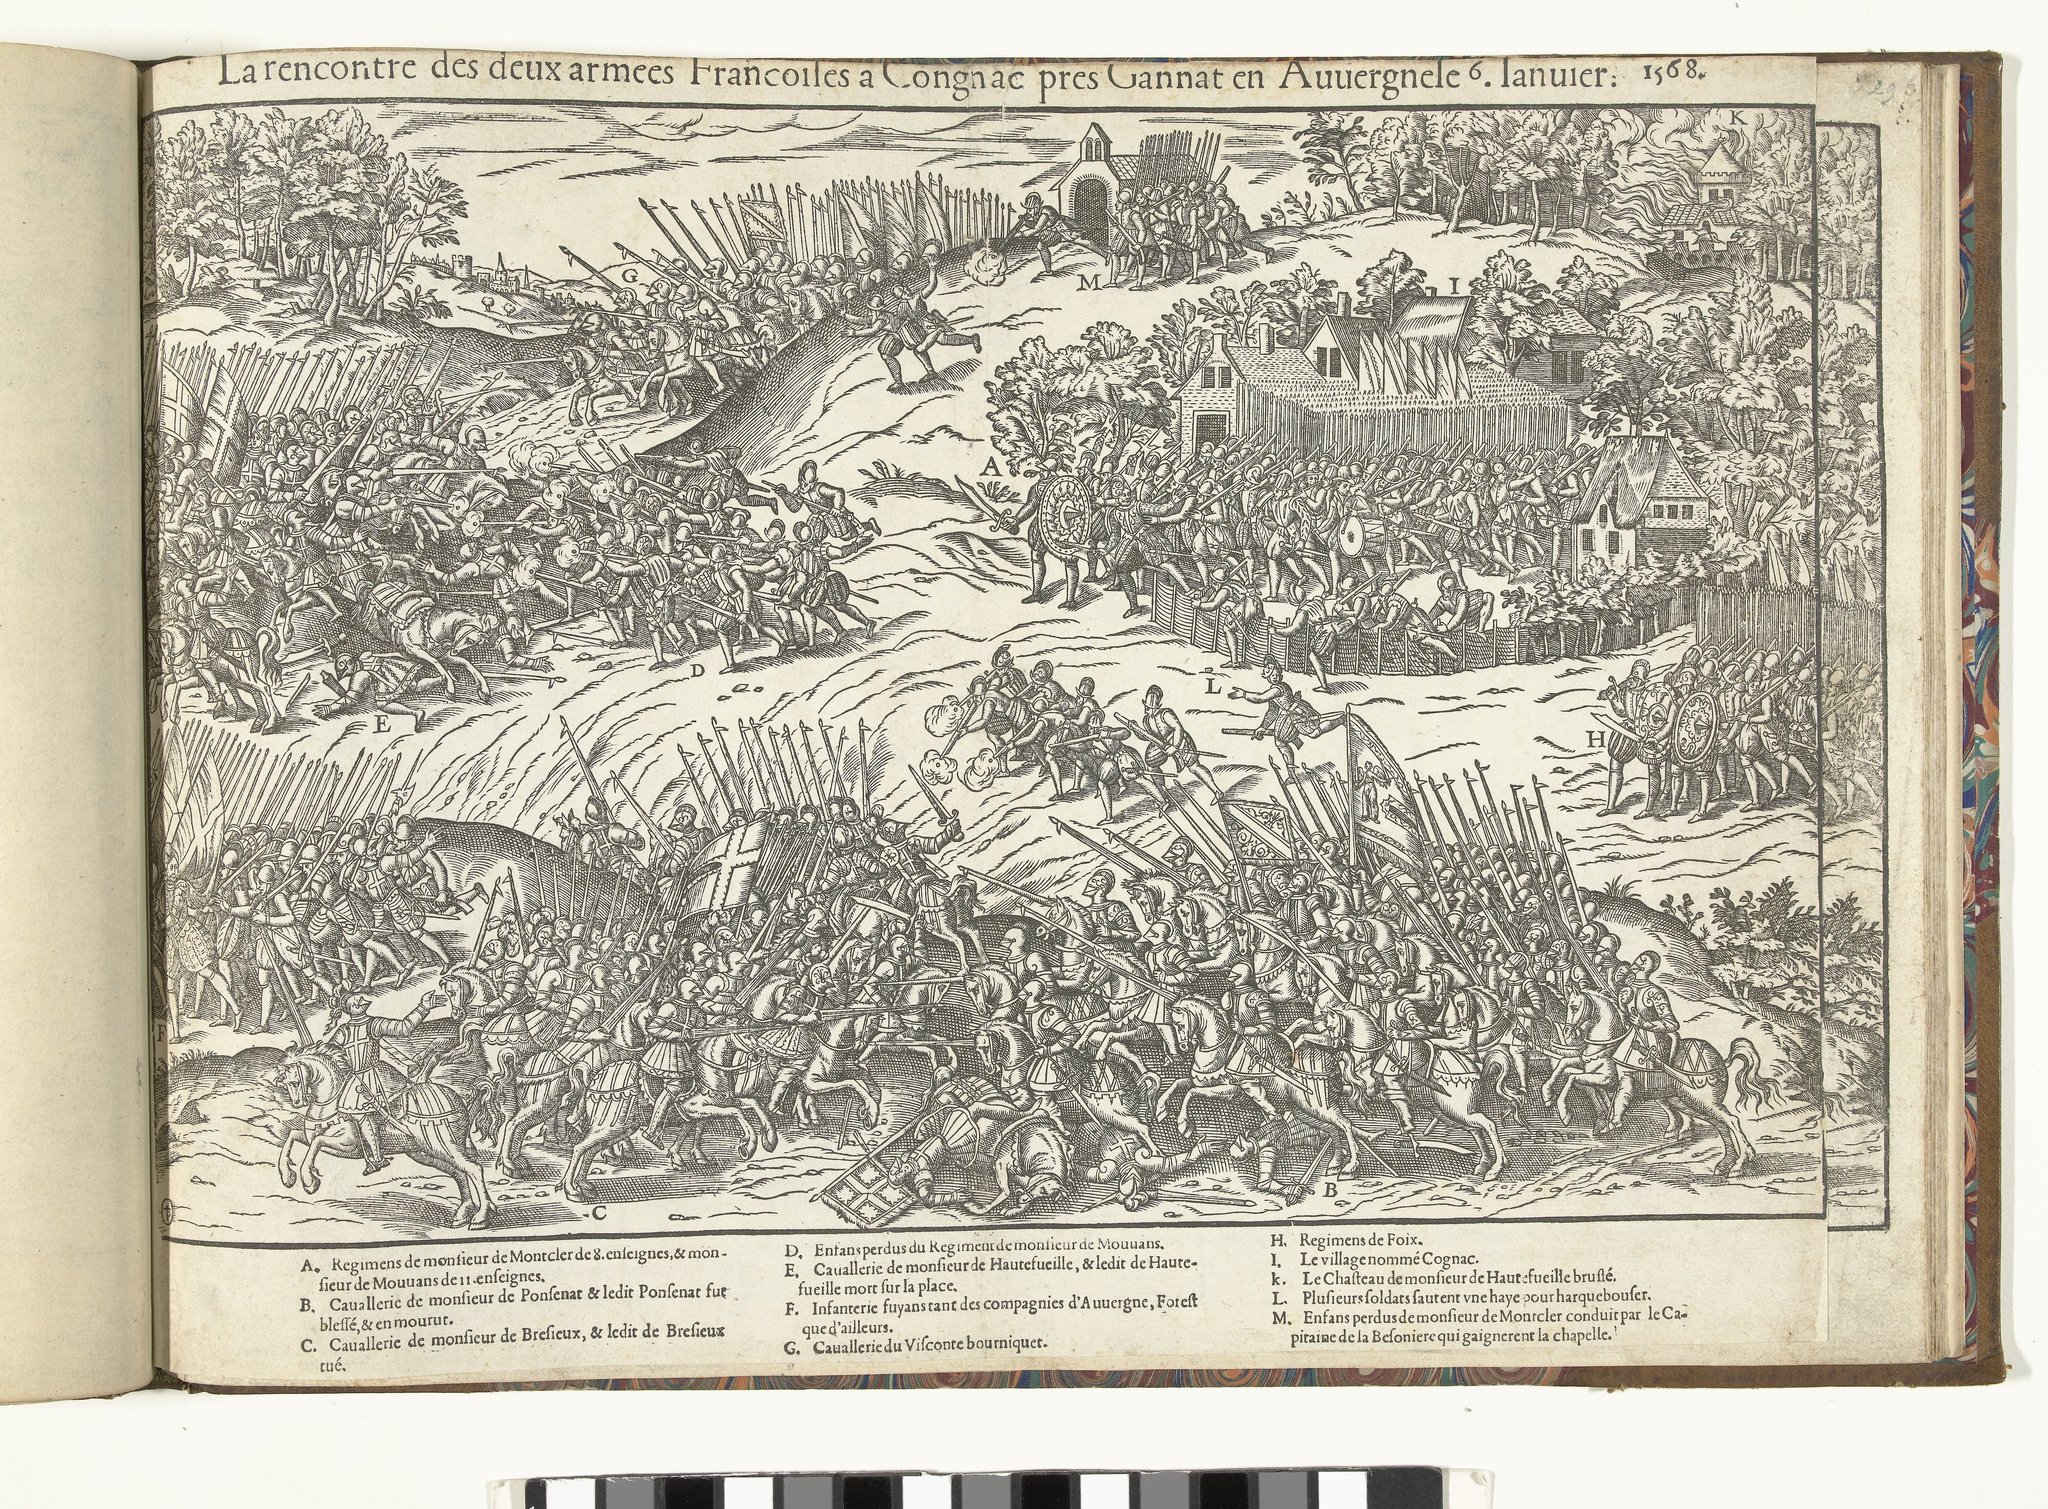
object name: print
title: La rencontre des deux armees Francoises a Congnac pres Gannat en Auvergnele 6. Janvier 1568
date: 1570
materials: paper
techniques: letterpress printing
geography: france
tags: battle, fighting in general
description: Slag bij Cognac in de Auvergne, 6 januari 1568. Gezicht op het slagveld. In het onderschrift de legenda A-M in het Frans. Ongenummerd.